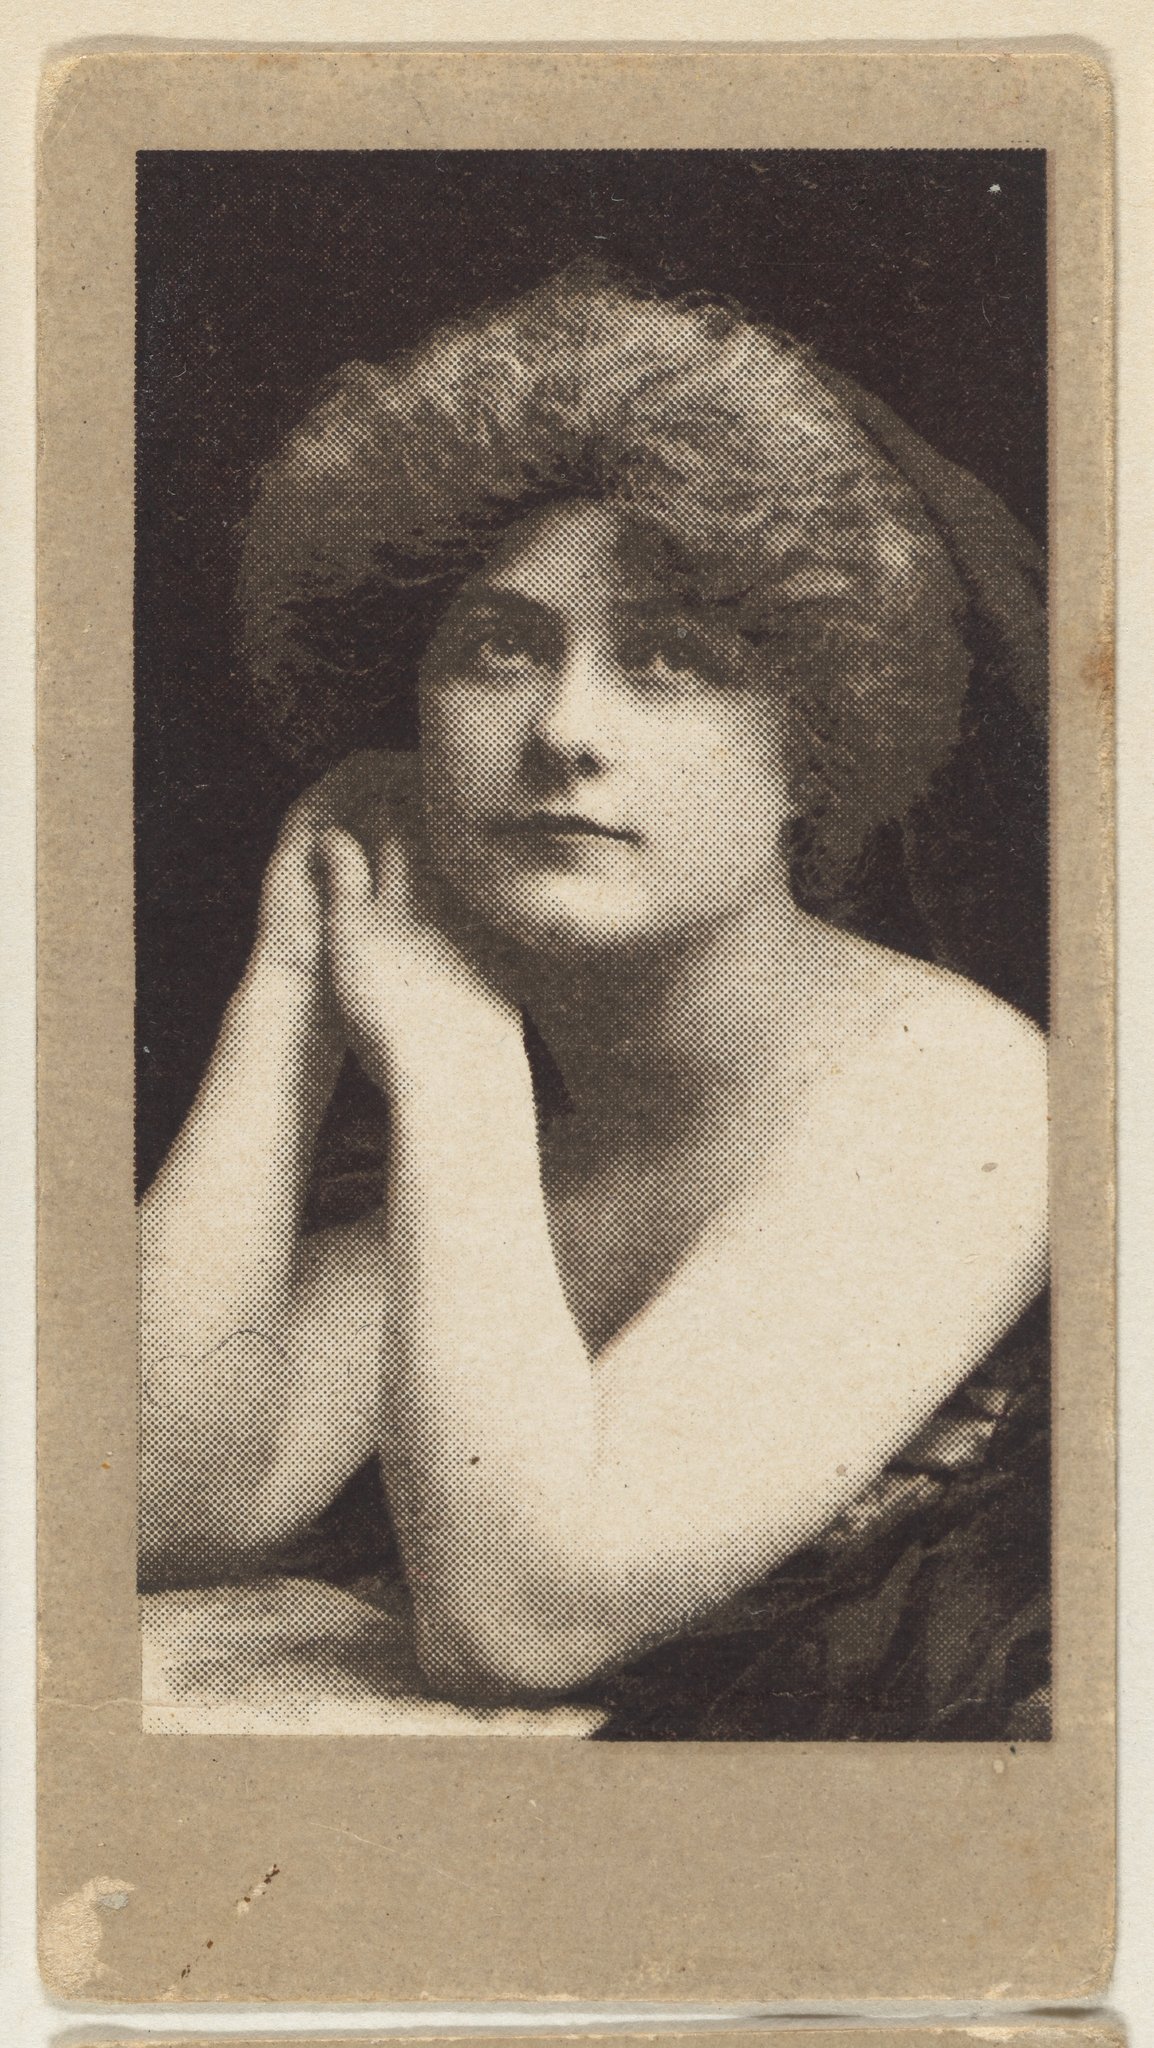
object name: print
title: Portrait of a woman looking upwards with her cheek resting on her hands, from the "Girls" series (T66), issued with Hunter Dog Cigarros by S. Monday & Sons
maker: s. monday & sons, brooklyn, new york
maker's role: publisher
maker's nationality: american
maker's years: 1850-1950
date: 1900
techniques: photolithograph